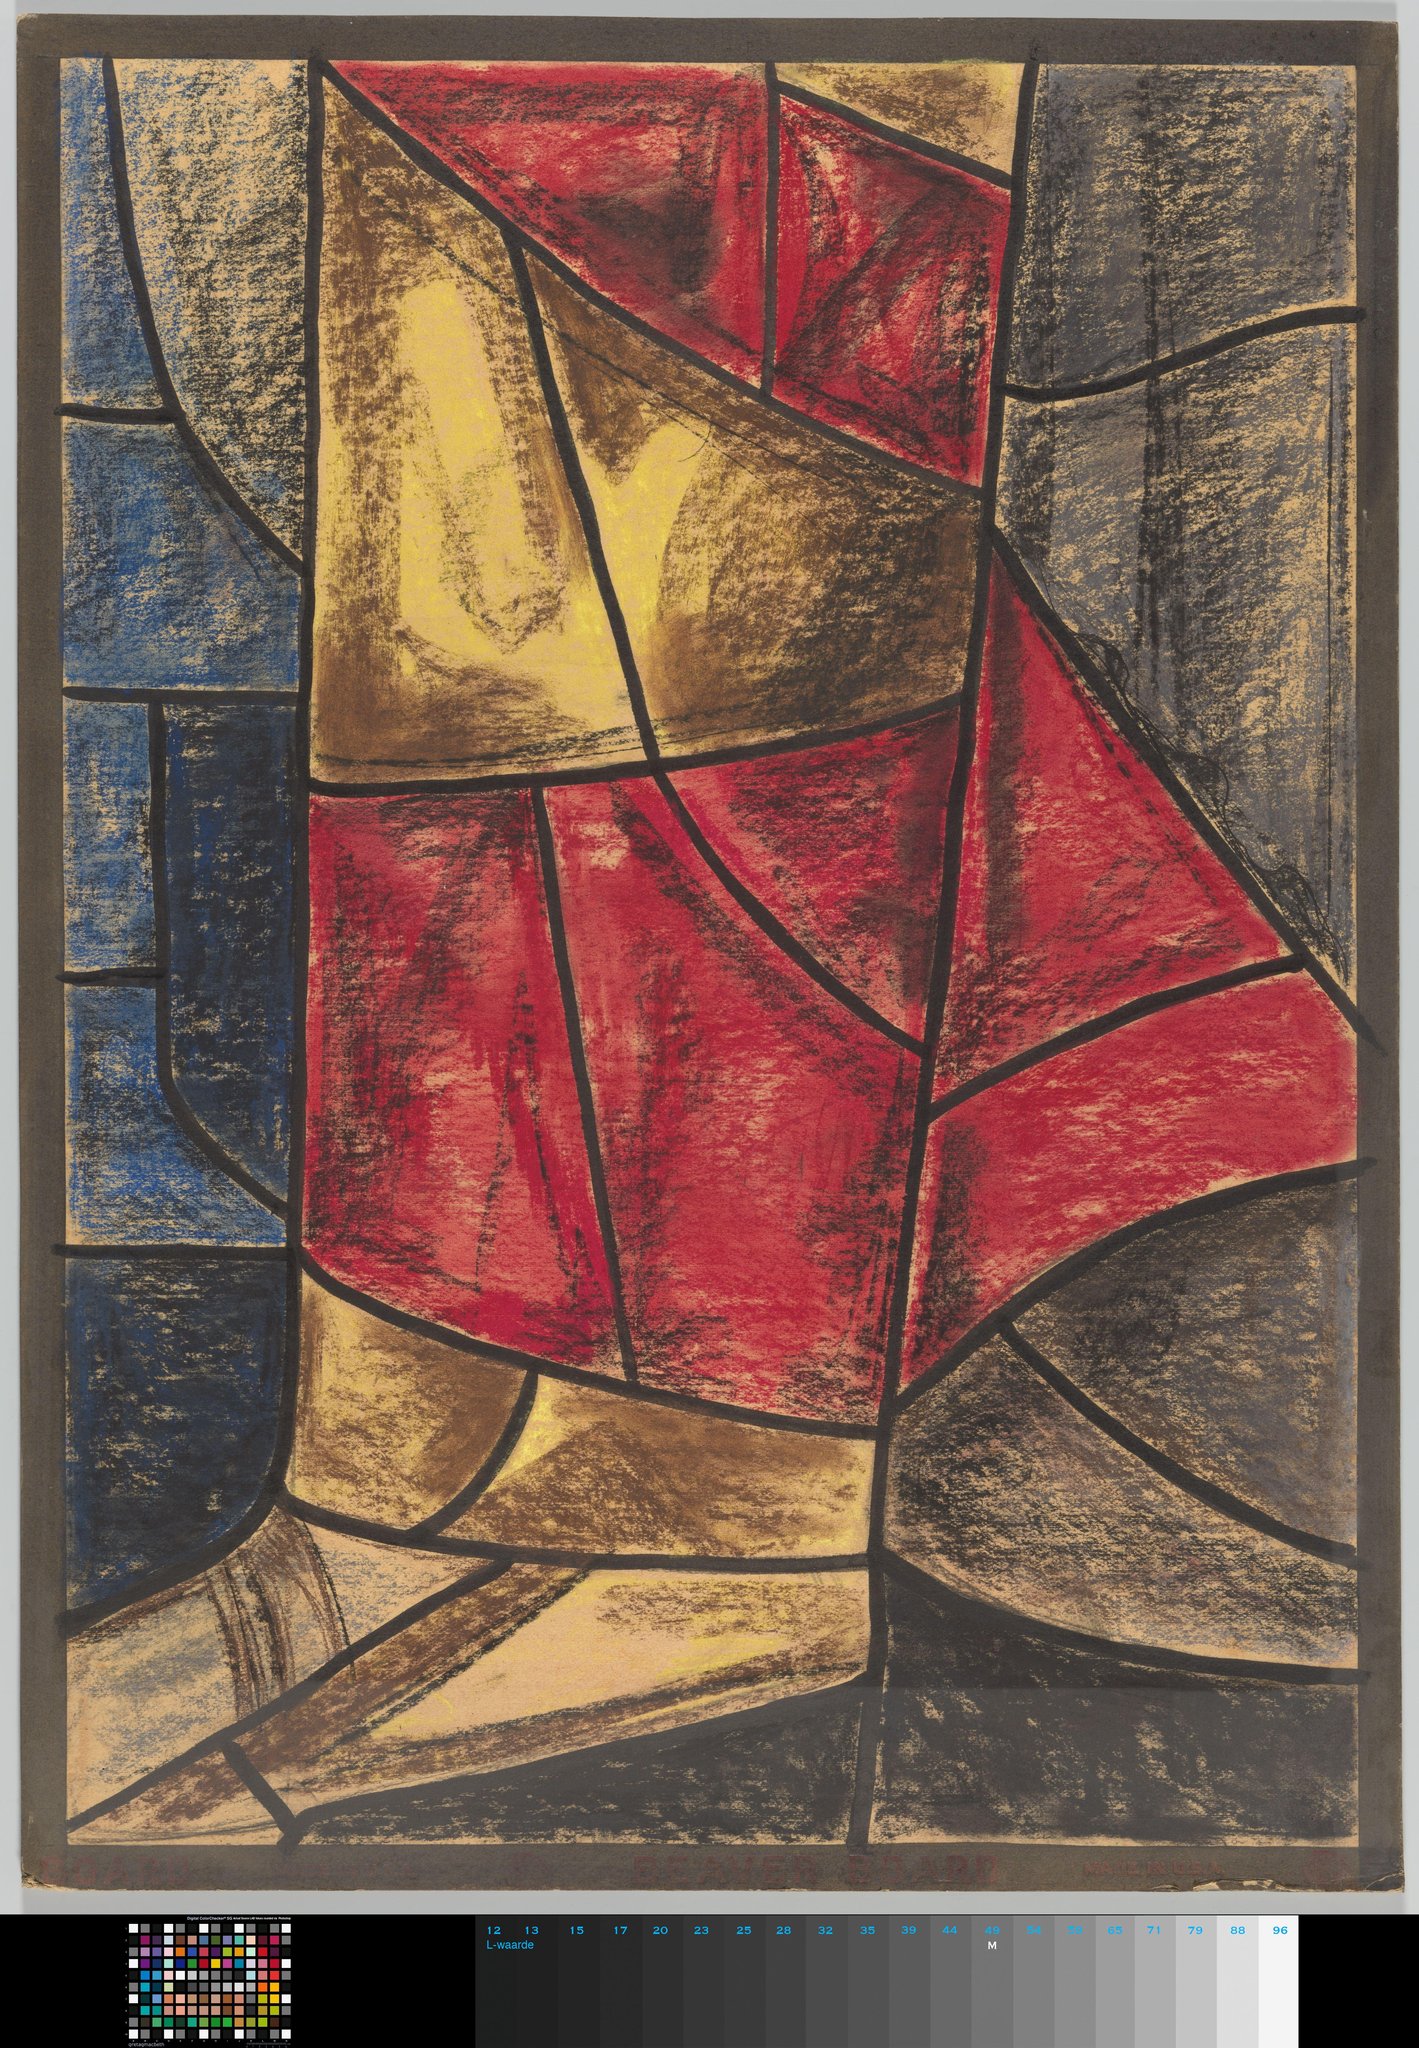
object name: design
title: Ontwerp voor raam in het Noordertransept in de Dom te Utrecht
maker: richard nicolaüs roland holst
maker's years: 1868-1938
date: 1934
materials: cardboard, chalk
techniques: brush